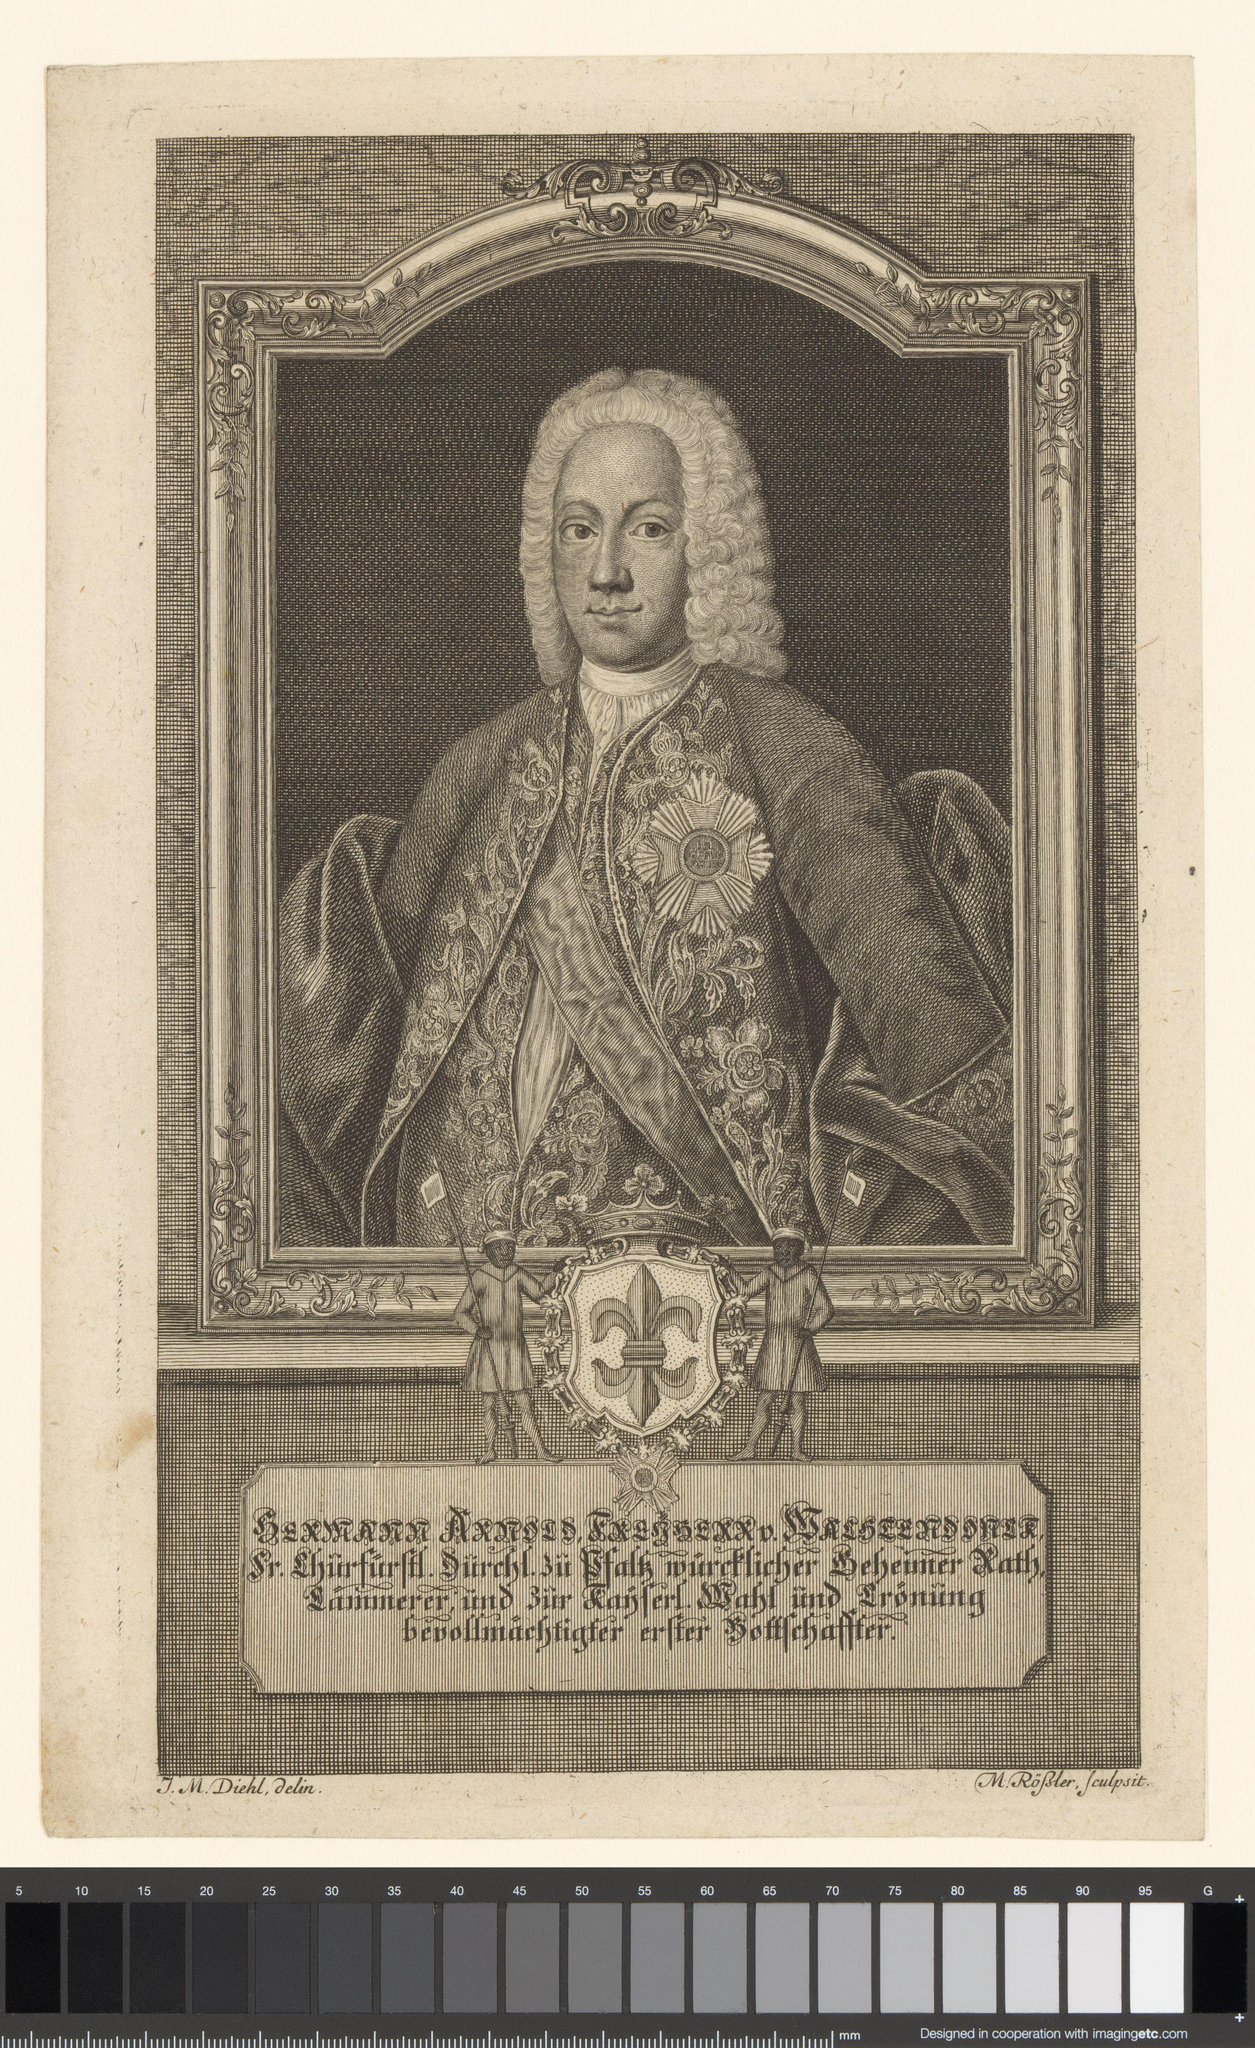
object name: print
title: Portret van Hermann Arnold, Freiherr von Wachtendonck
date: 1715-1777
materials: paper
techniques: engraving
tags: historical persons, armorial bearing, heraldry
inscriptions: collector's mark: Lugt 2228